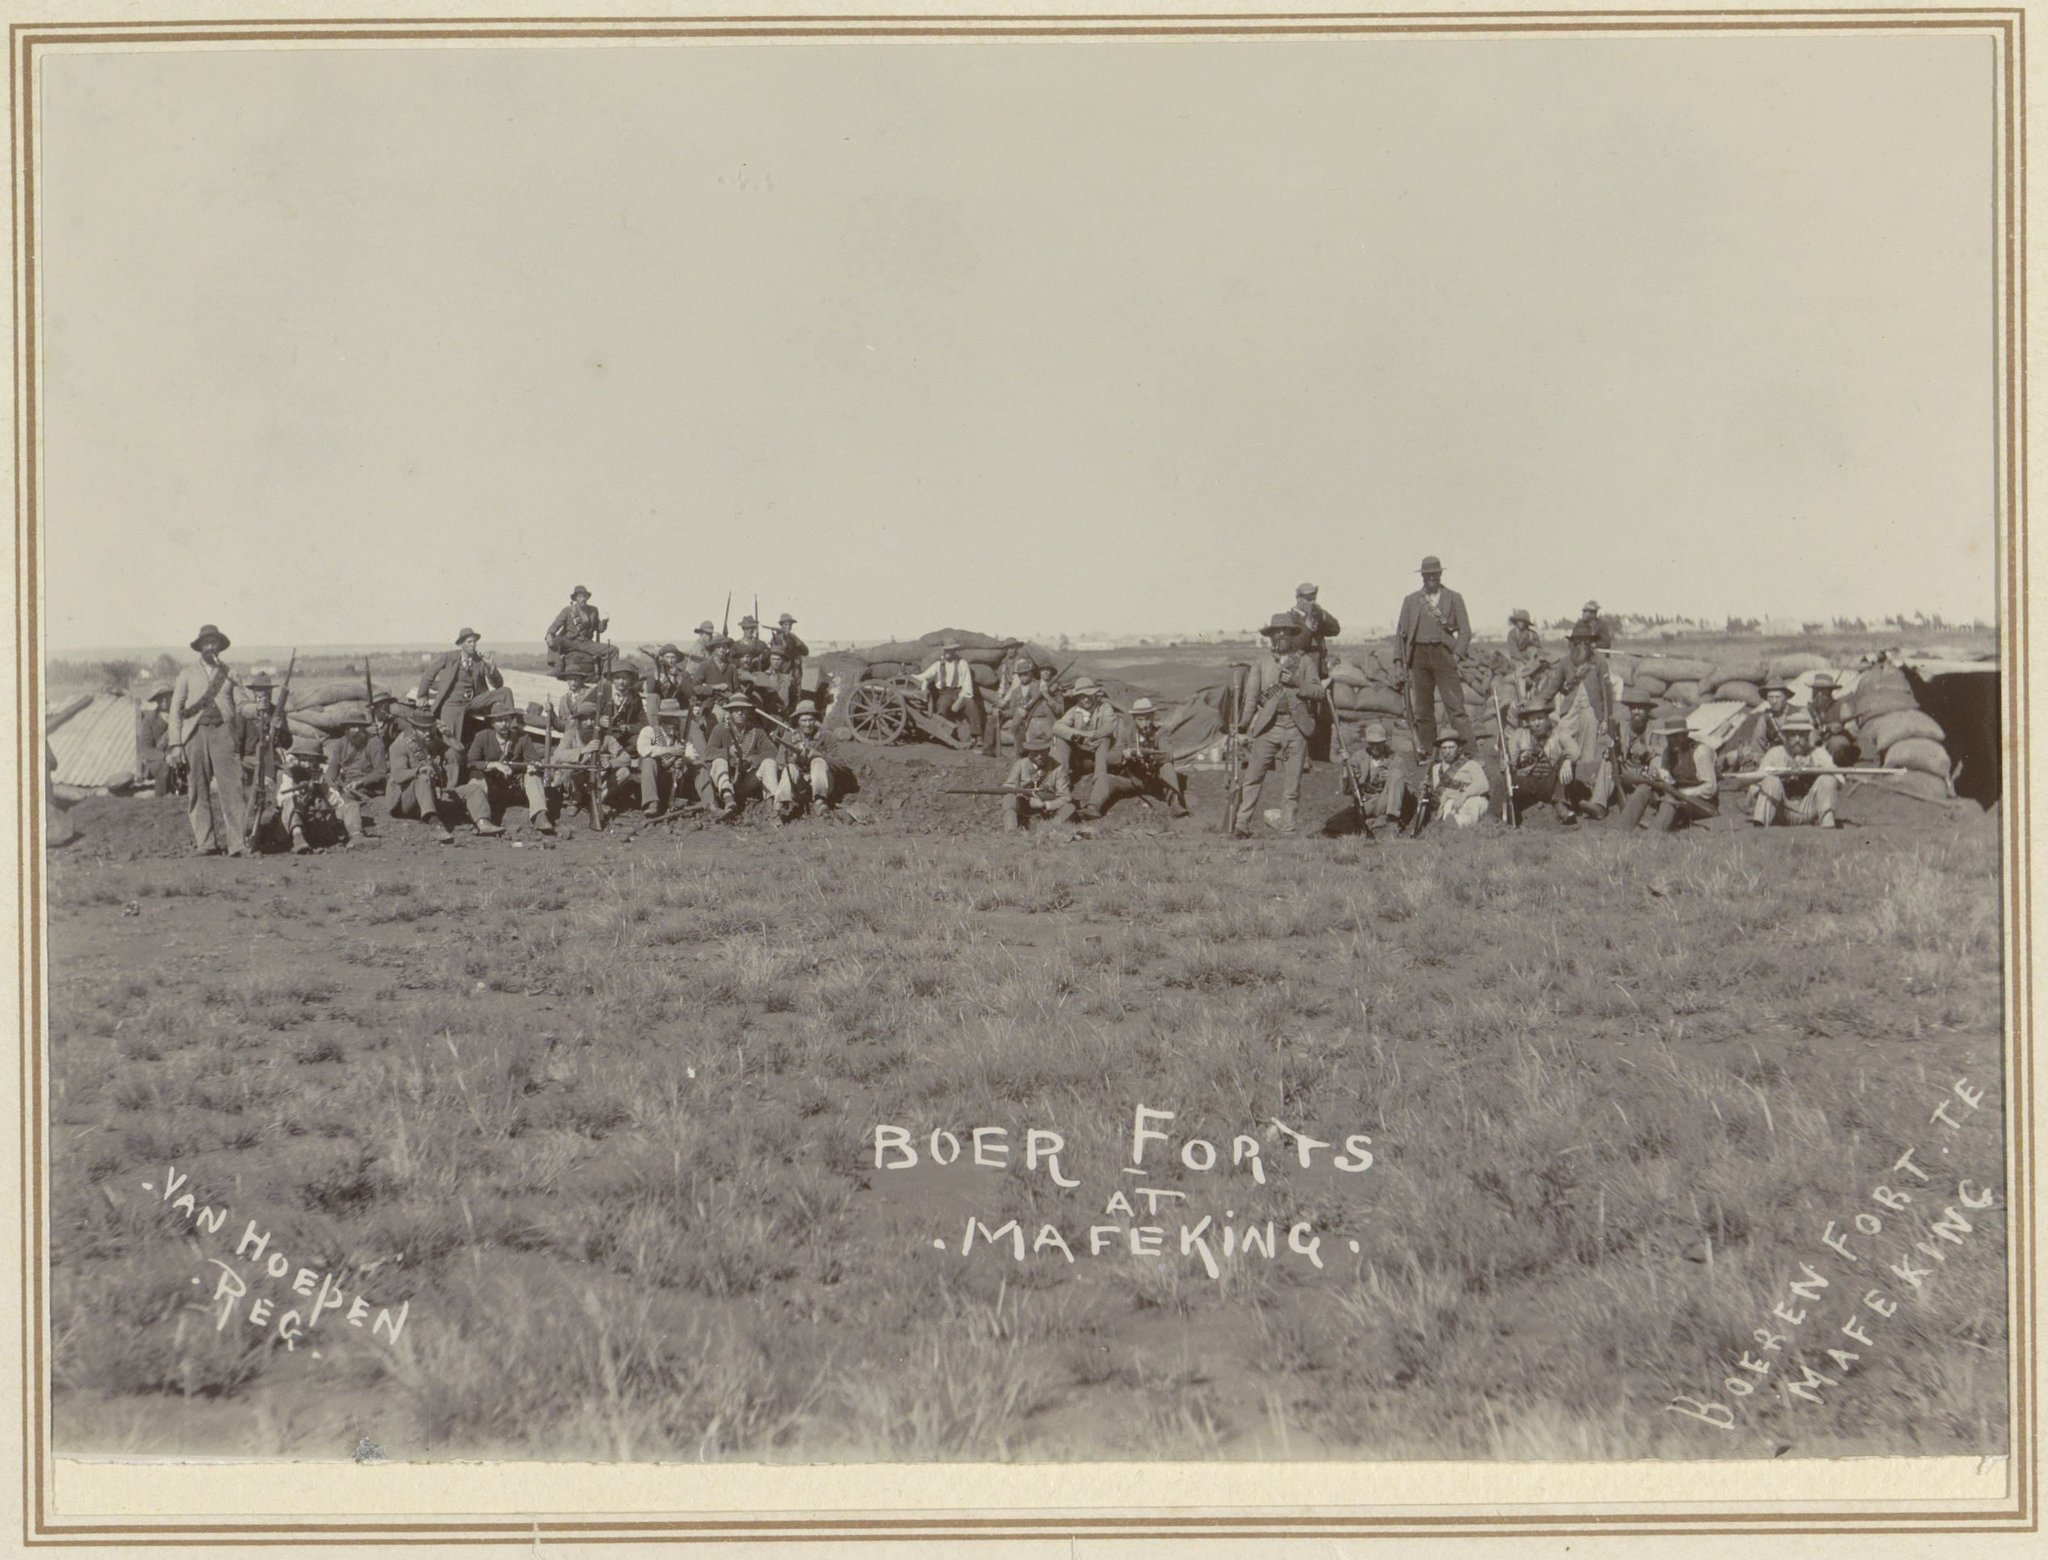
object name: album leaf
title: Boer forts at Mafeking. Boerenfort te Mafeking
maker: jan van hoepen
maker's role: fotograaf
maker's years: 1856-1922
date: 1899-1900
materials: cardboard, paper, photographic support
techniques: gelatin silver print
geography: mafeking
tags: defensive measures (military) (+ land forces)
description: Onderdeel van Fotoalbum met opnames van de Tweede Boerenoorlog (1899-1902).